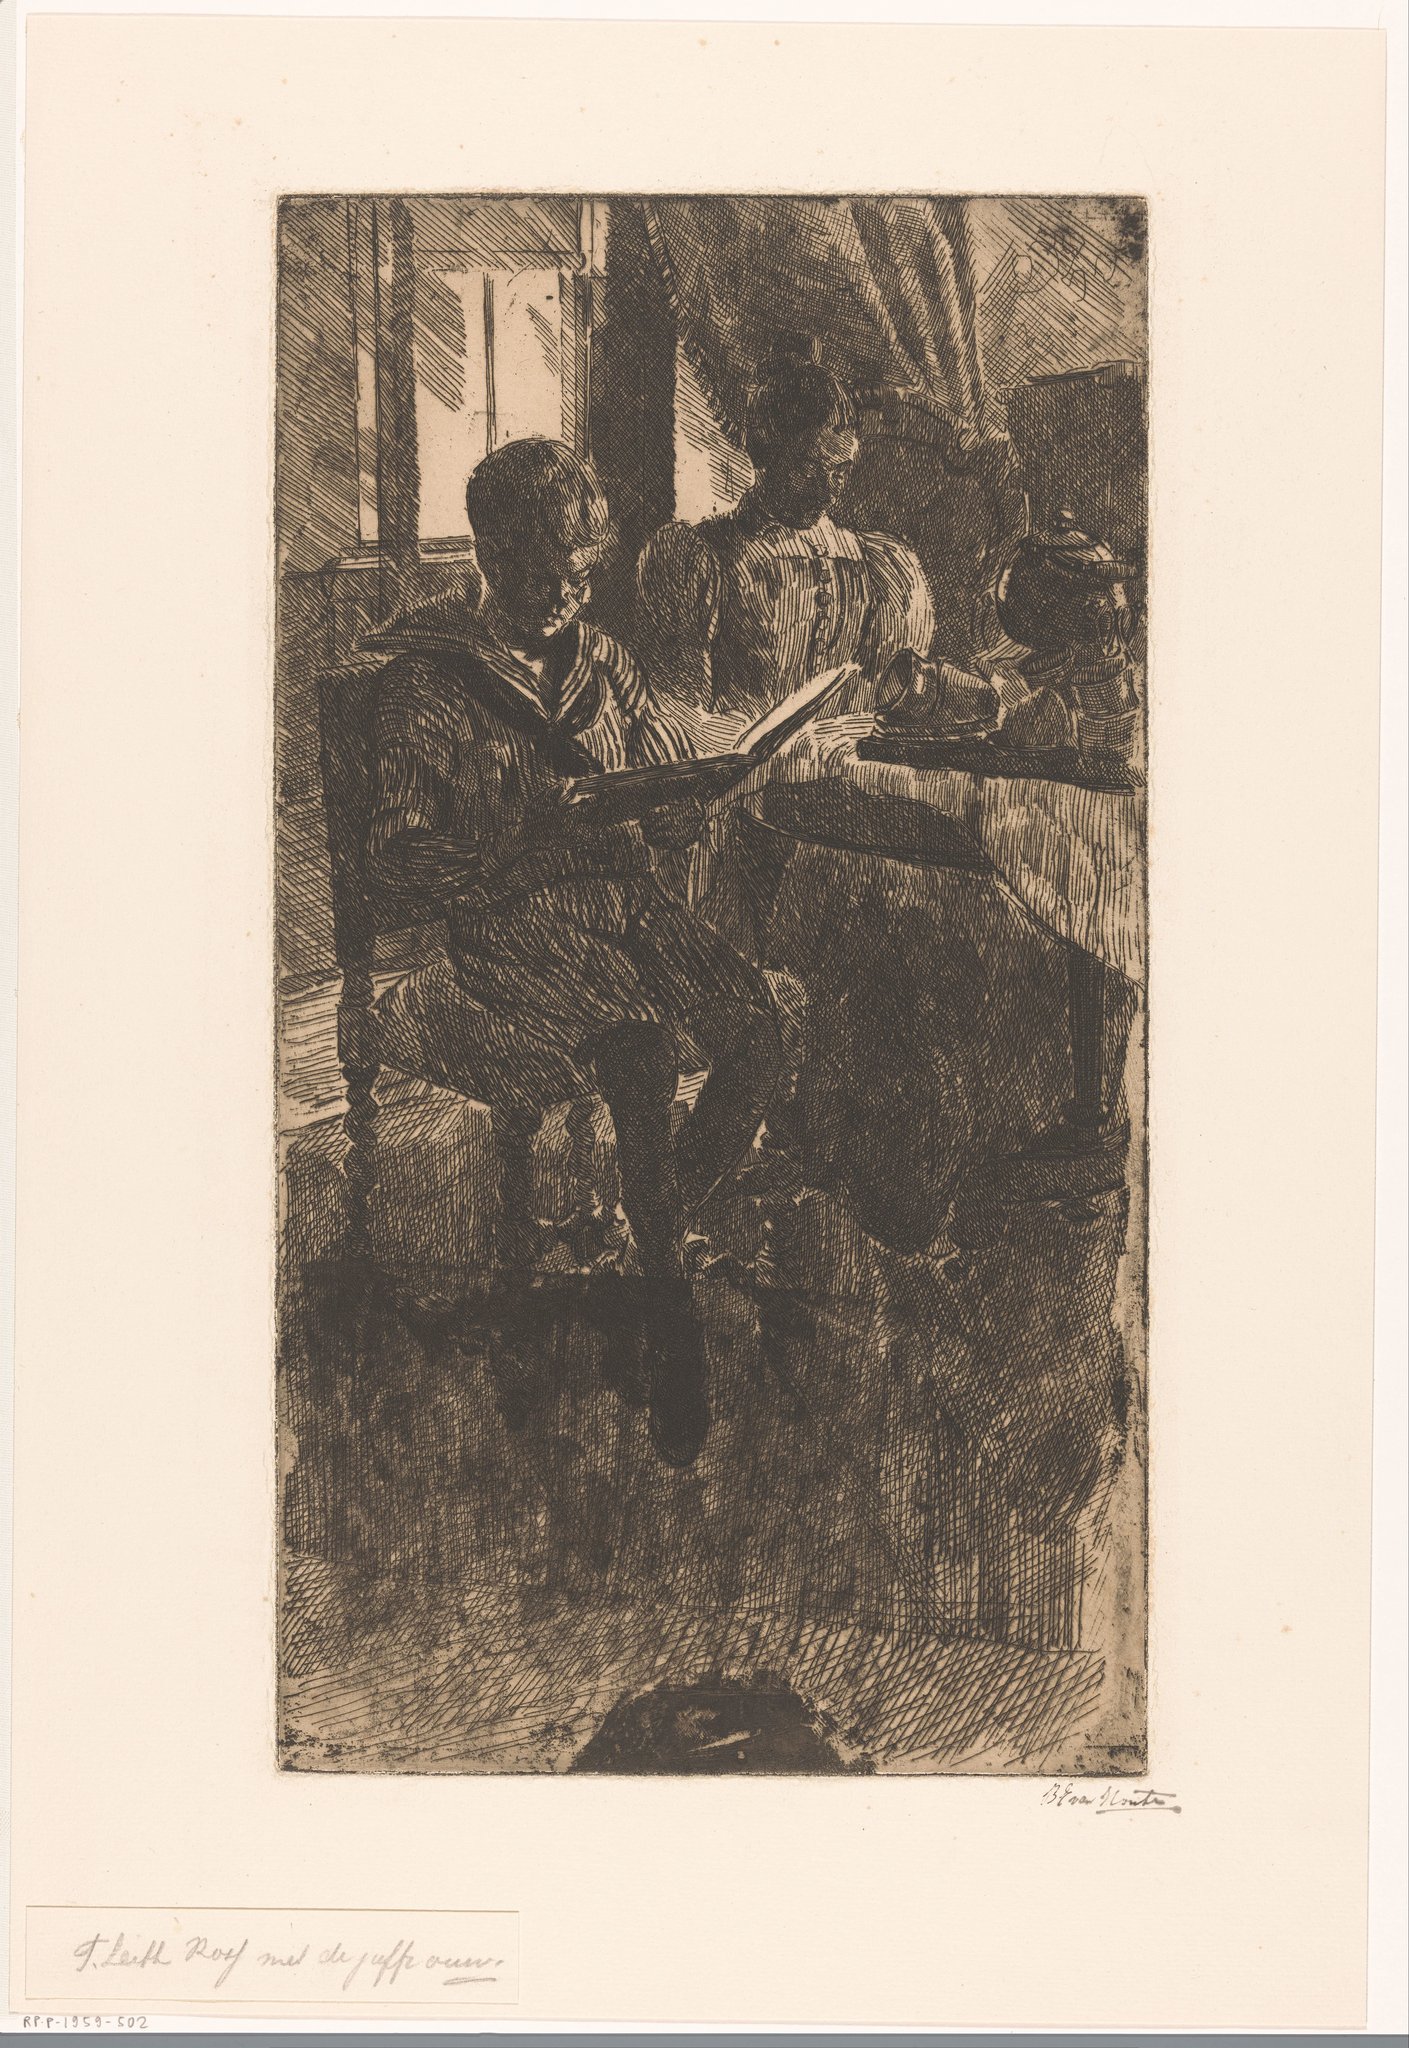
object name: print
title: F. Leith Ross met de juffrouw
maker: barbara elisabeth van houten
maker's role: draughtsman, print maker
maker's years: 1862-1950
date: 1872-1950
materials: paper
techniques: etching, intaglio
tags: reading, tea- and coffee-service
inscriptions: collector's mark: Lugt 2228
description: Frederick William Leith-Ross, een zoon van Sina van Houten, zittend aan tafel met een boek. Naast hem een vrouw, mogelijk Sina van Houten of één van de andere zussen van Barbara Elisabeth van Houten. Op de tafel een theeservies.